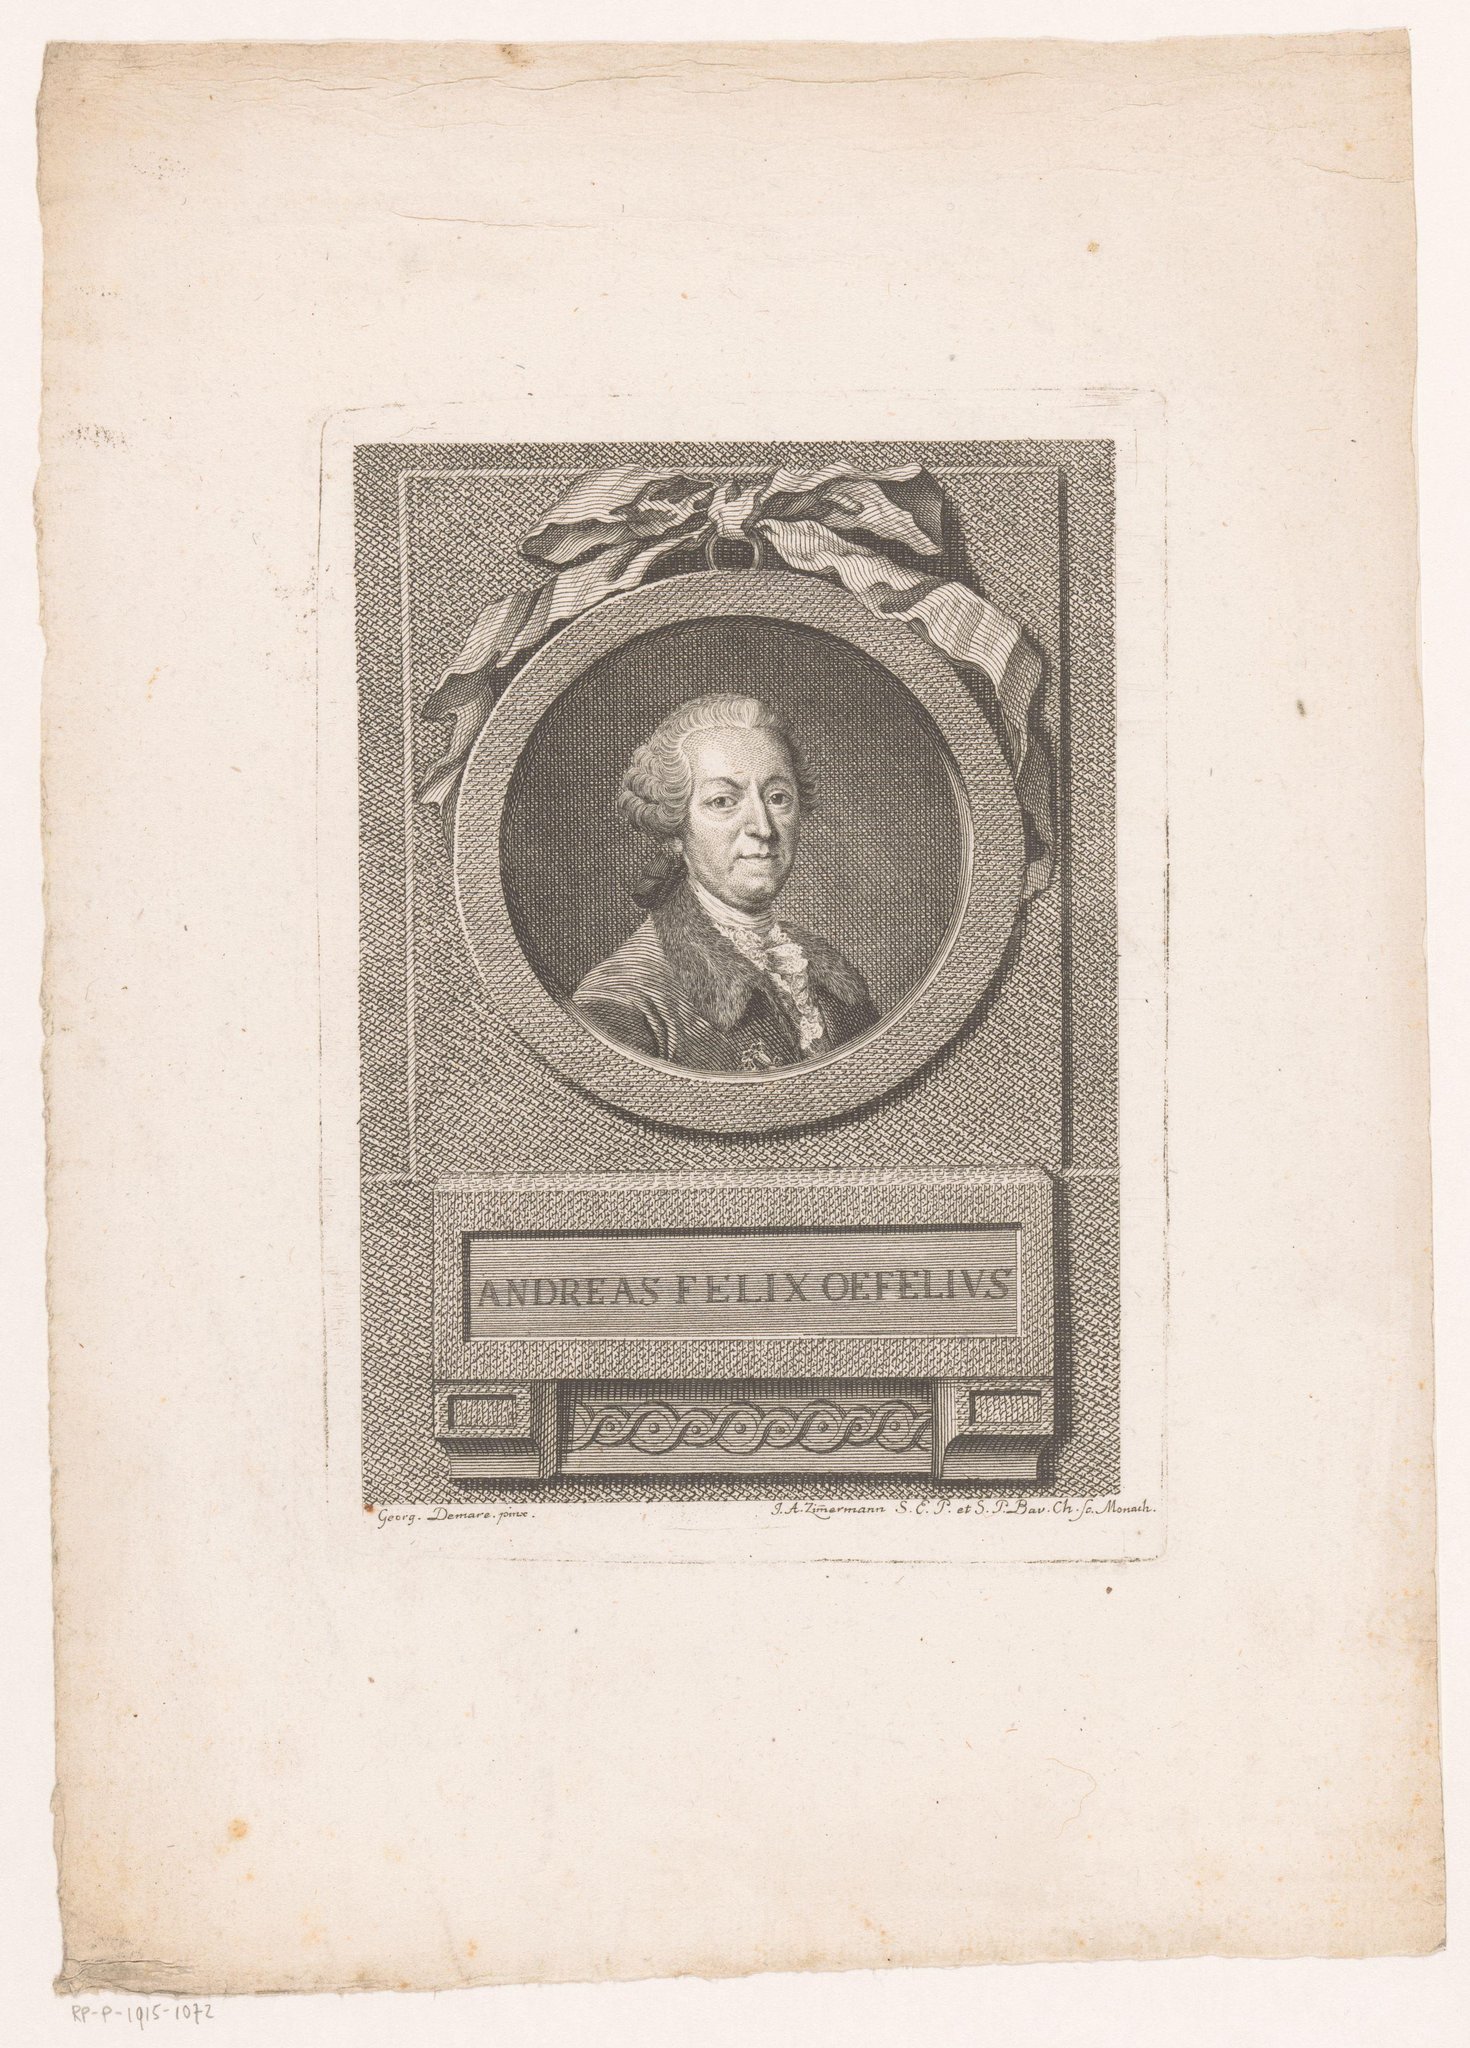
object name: print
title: Portret van Andreas Felix Oefele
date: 1745-1797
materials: paper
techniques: engraving, etching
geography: munich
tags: historical persons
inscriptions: collector's mark: Lugt 2228